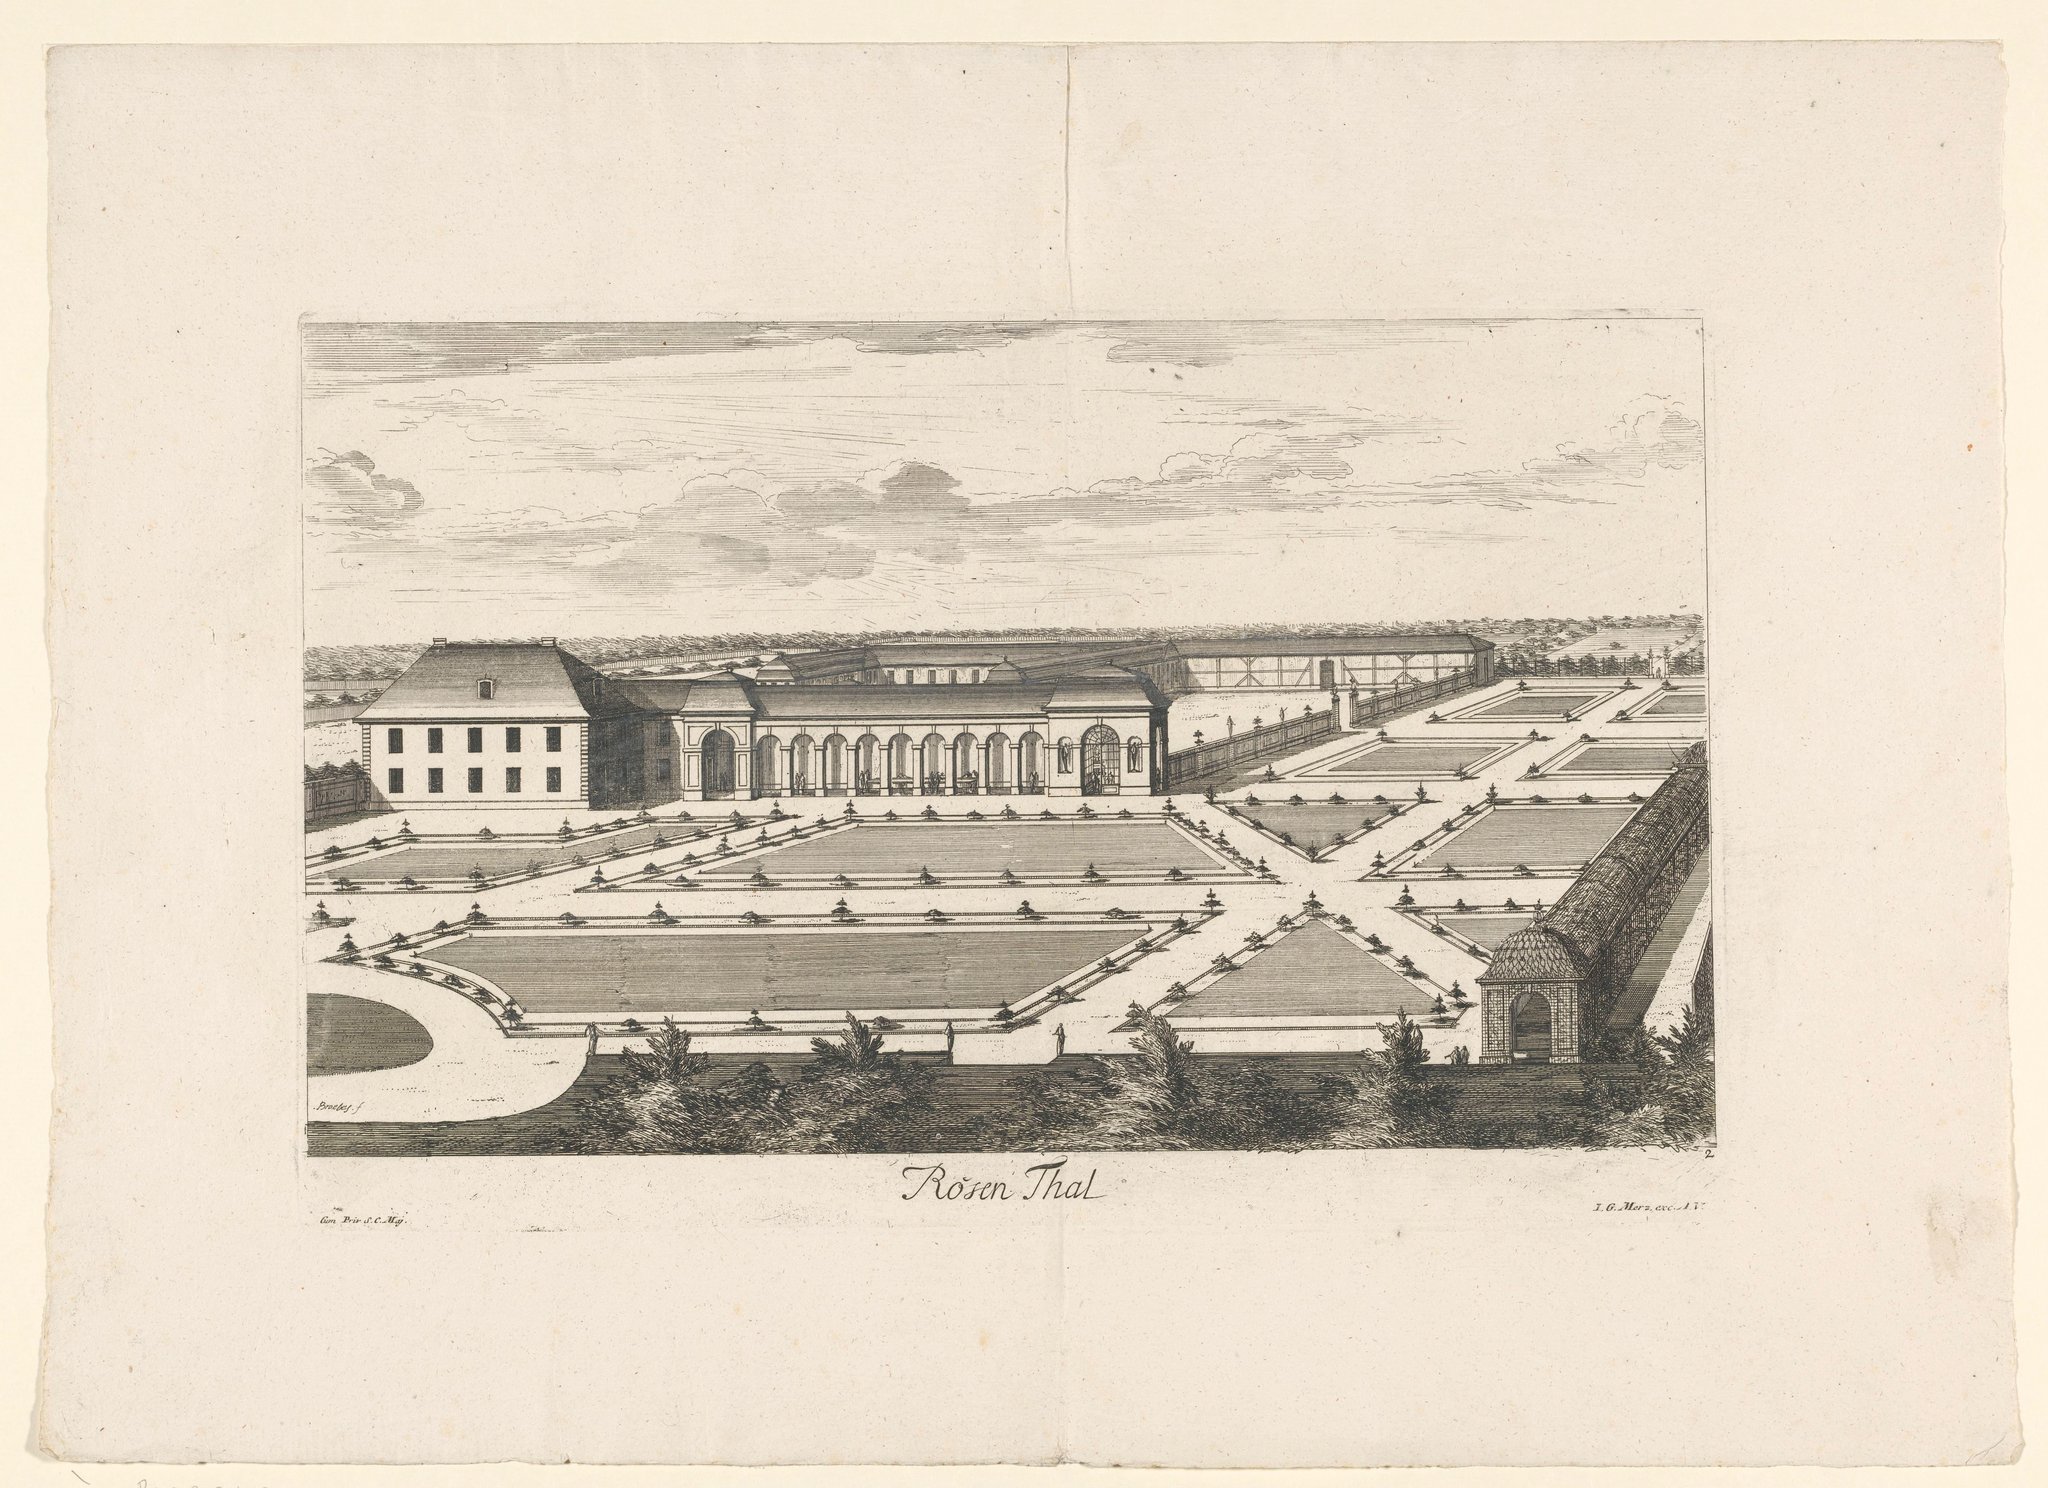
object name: book illustration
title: Gezicht op Slot Rosenthal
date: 1733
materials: paper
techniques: engraving, etching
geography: augsburg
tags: palace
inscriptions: collector's mark: Lugt 2228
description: Prent gebruikt in: Broesbes, Jean-Baptiste. Vues des Palais et Maisons de Plaisance de Sa Majesté le Roy de Prusse. Augsburg: Johann Georg Merz, 1733.